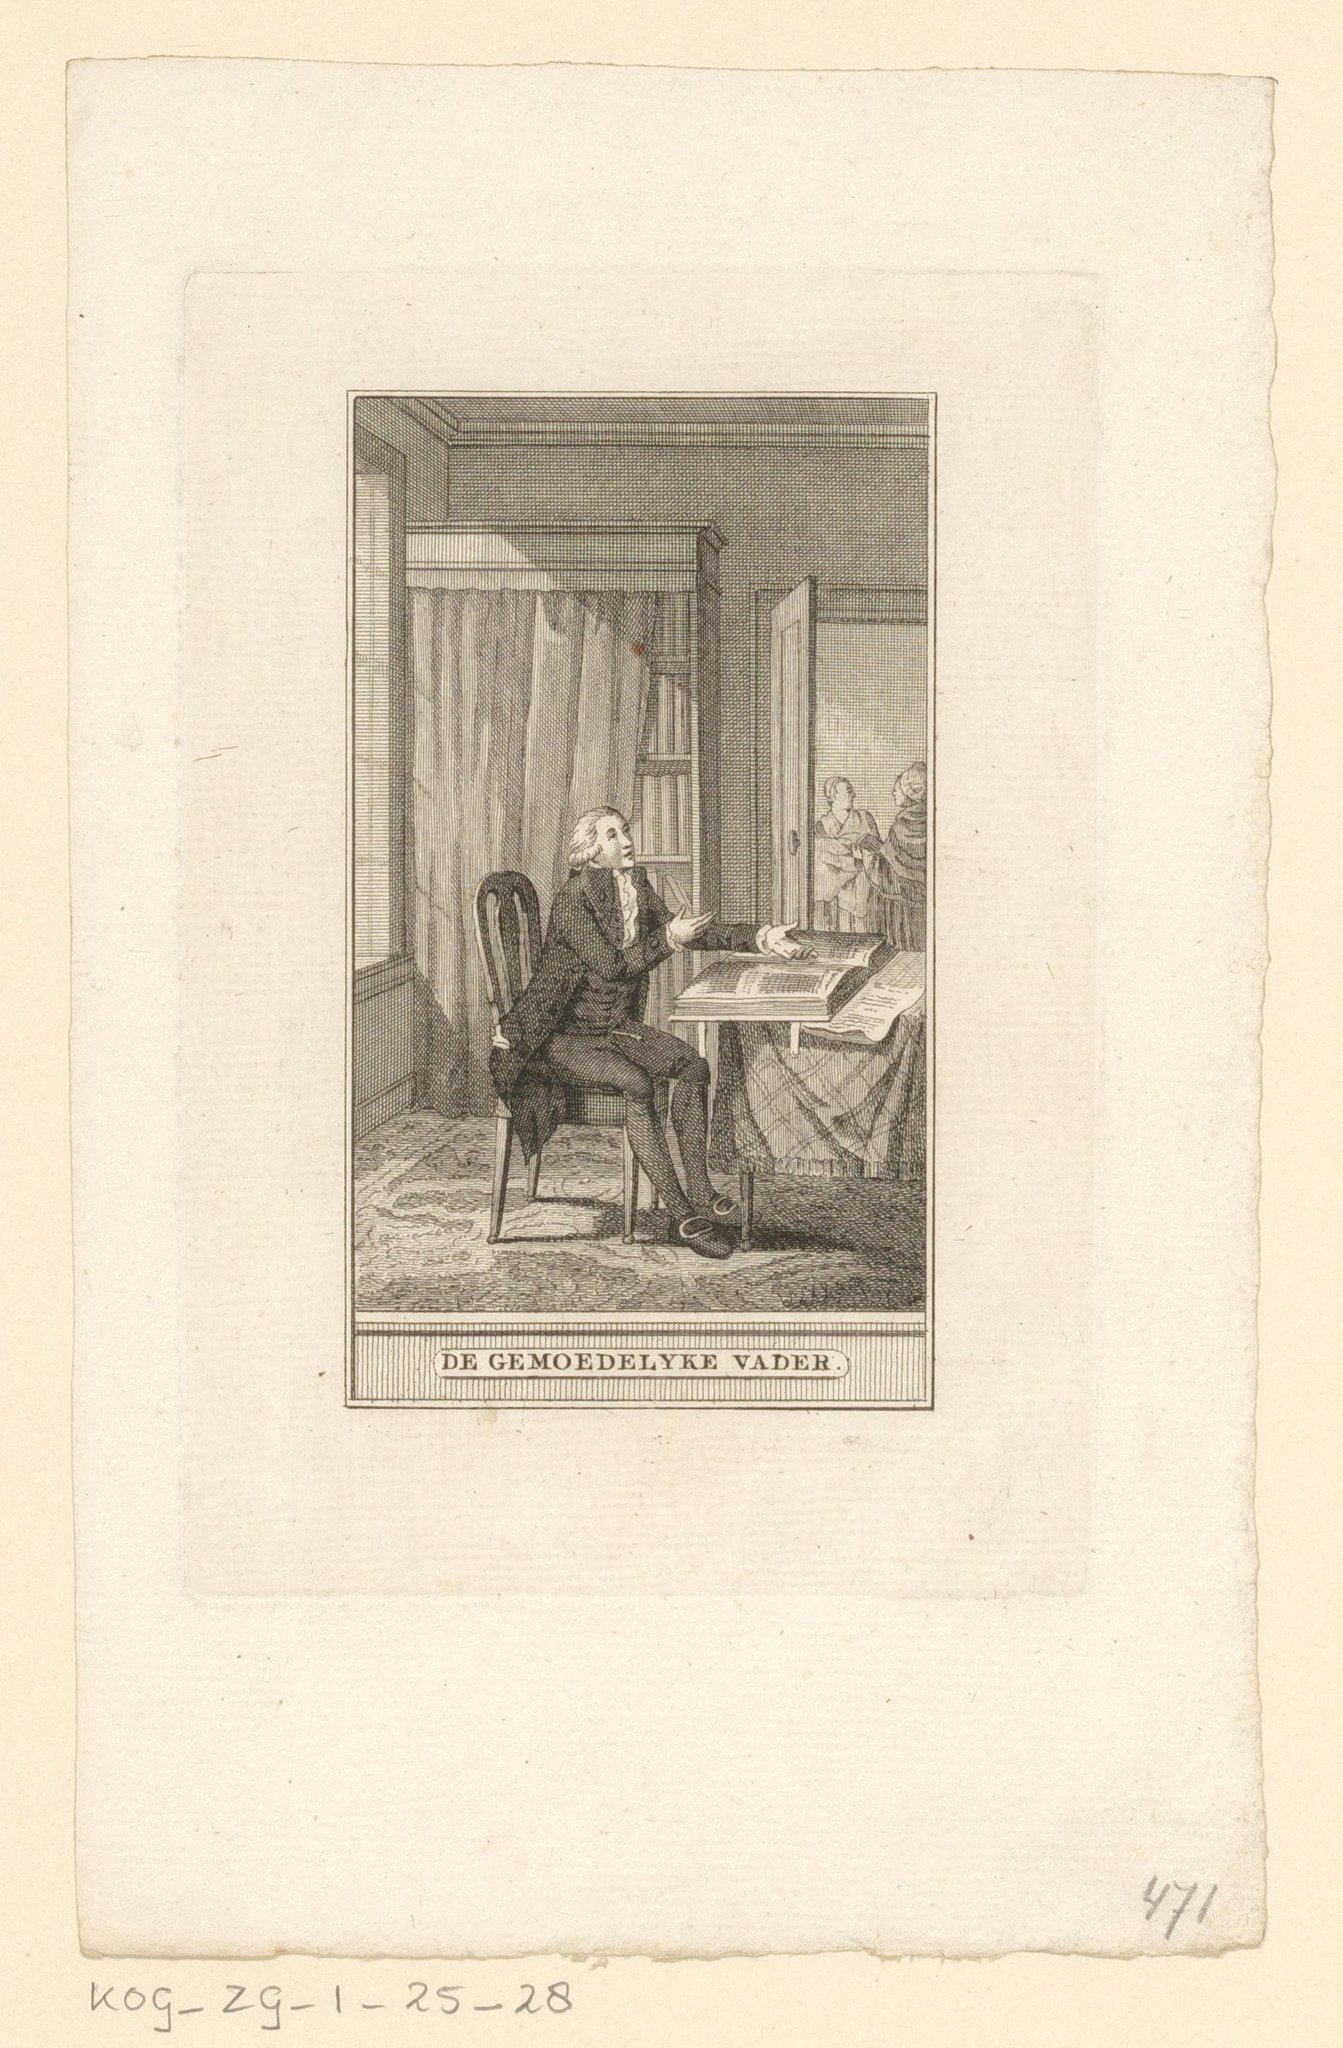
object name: print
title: De Gemoedelyke vader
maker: Anonymous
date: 1798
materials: paper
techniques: etching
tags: book - mm - book open, study; 'studiolo'; library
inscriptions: stamp, collector's mark: Lugt 1641, stamp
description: Onderwerpsrubrieken binnen de Atlas Zeden en Gewoonten: Zeden en Gewoonten in Engeren Zin, De Woning, Binnenhuizen, Boekerijen.